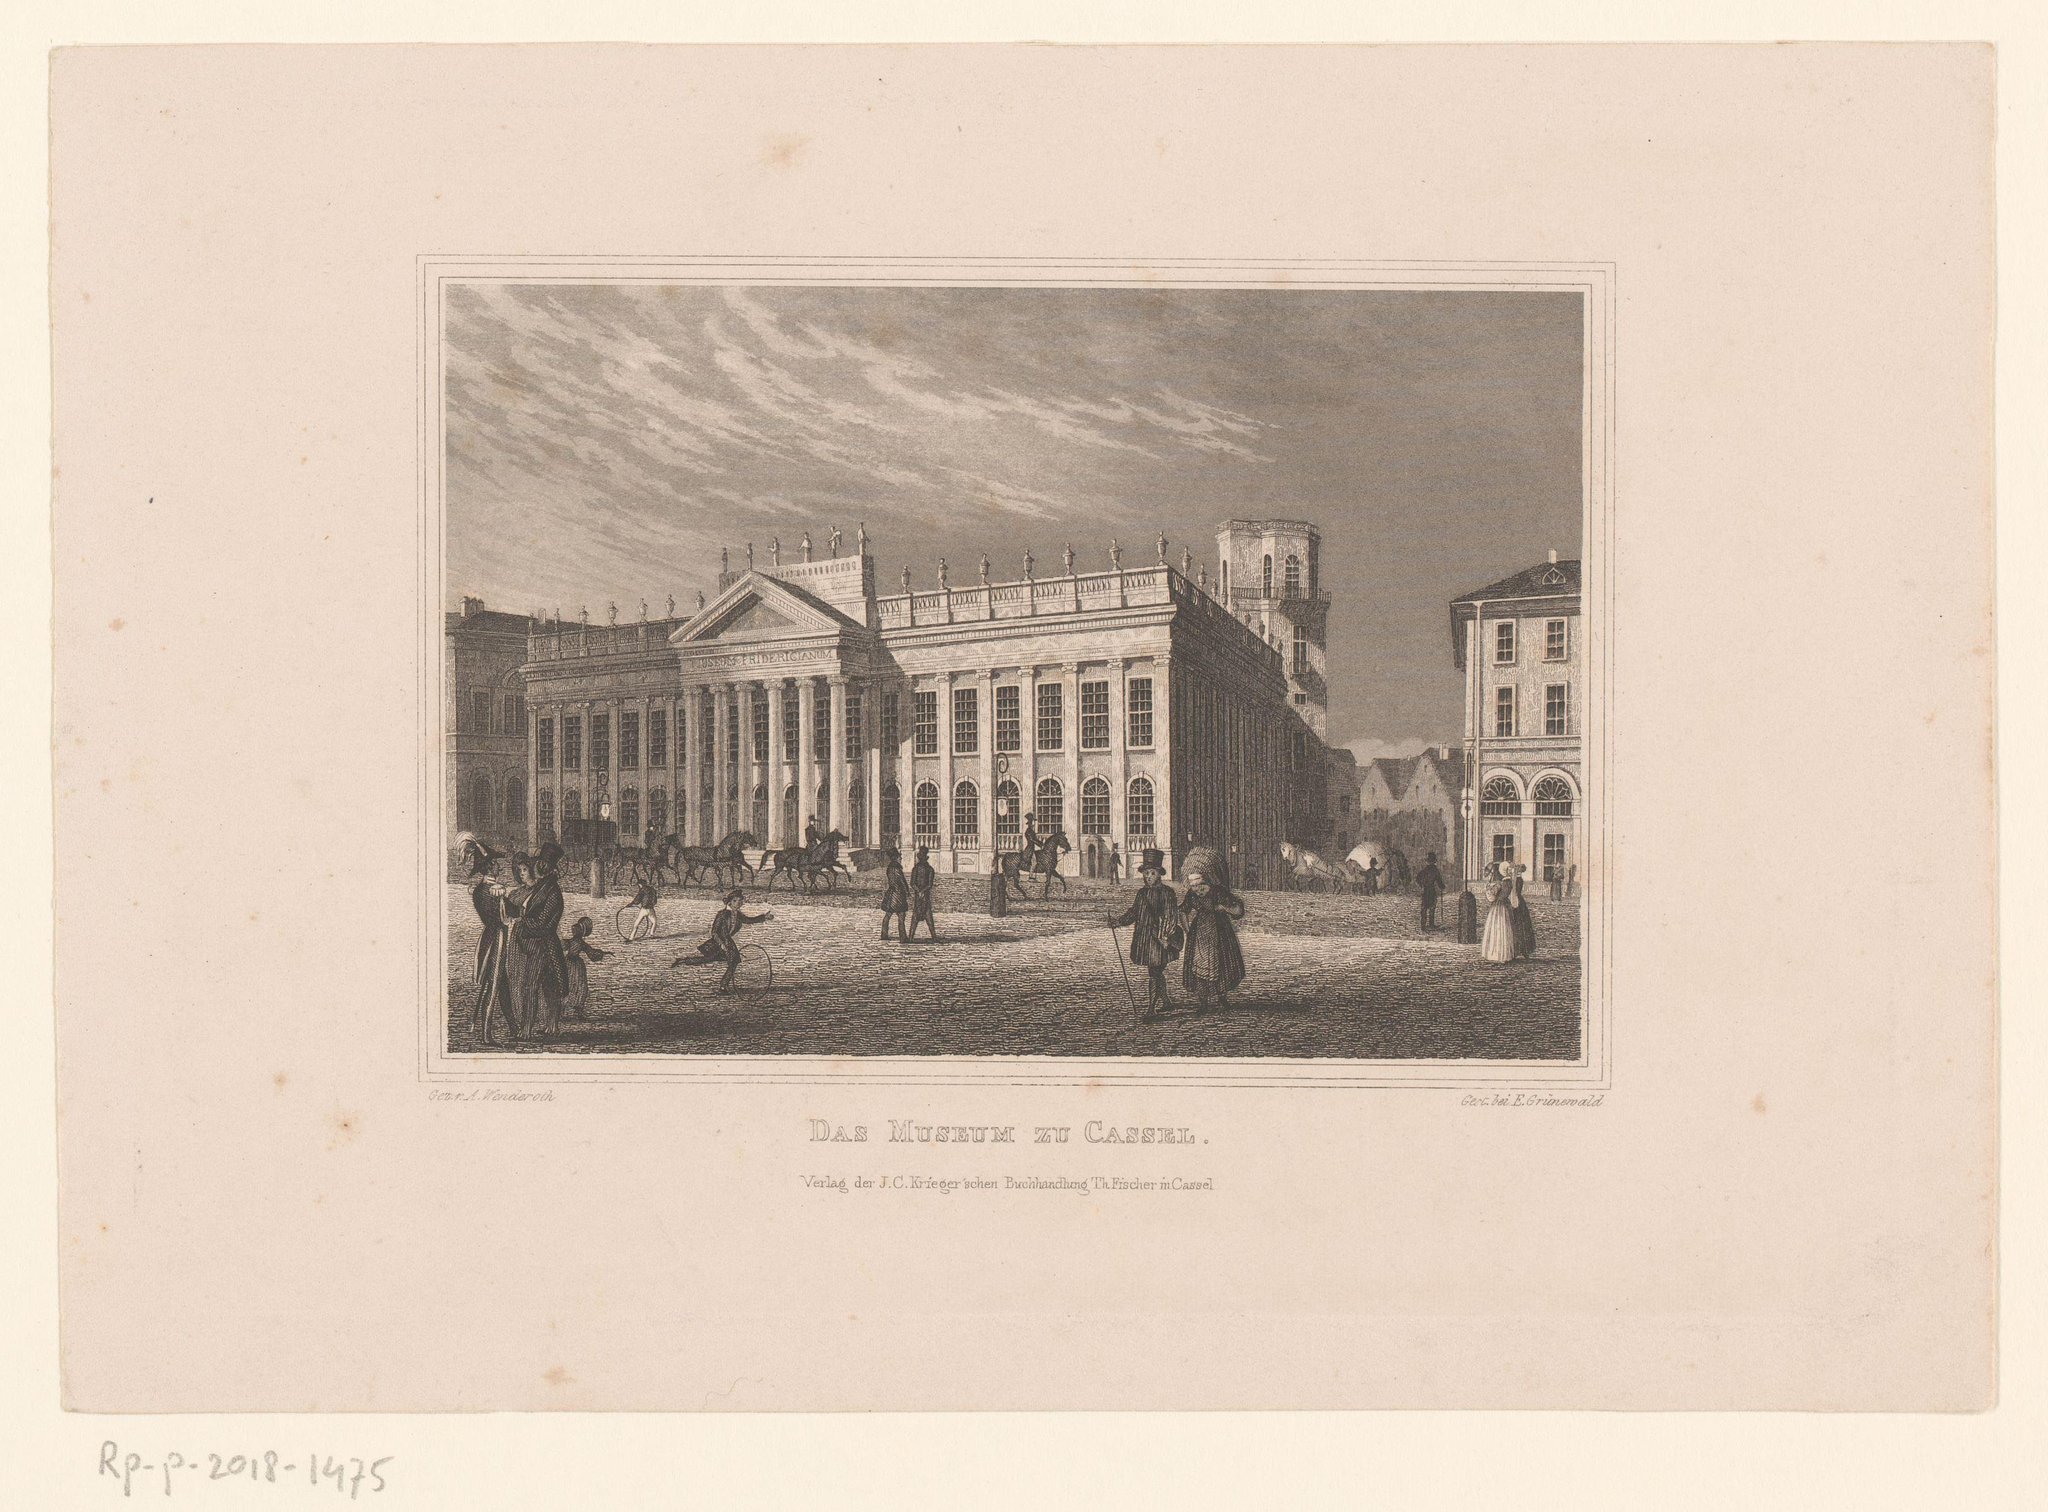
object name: print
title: Das Museum zu Cassel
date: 1831-1863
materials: paper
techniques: engraving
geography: kassel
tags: permanent exhibition, museum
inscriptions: collector's mark: Lugt 2228